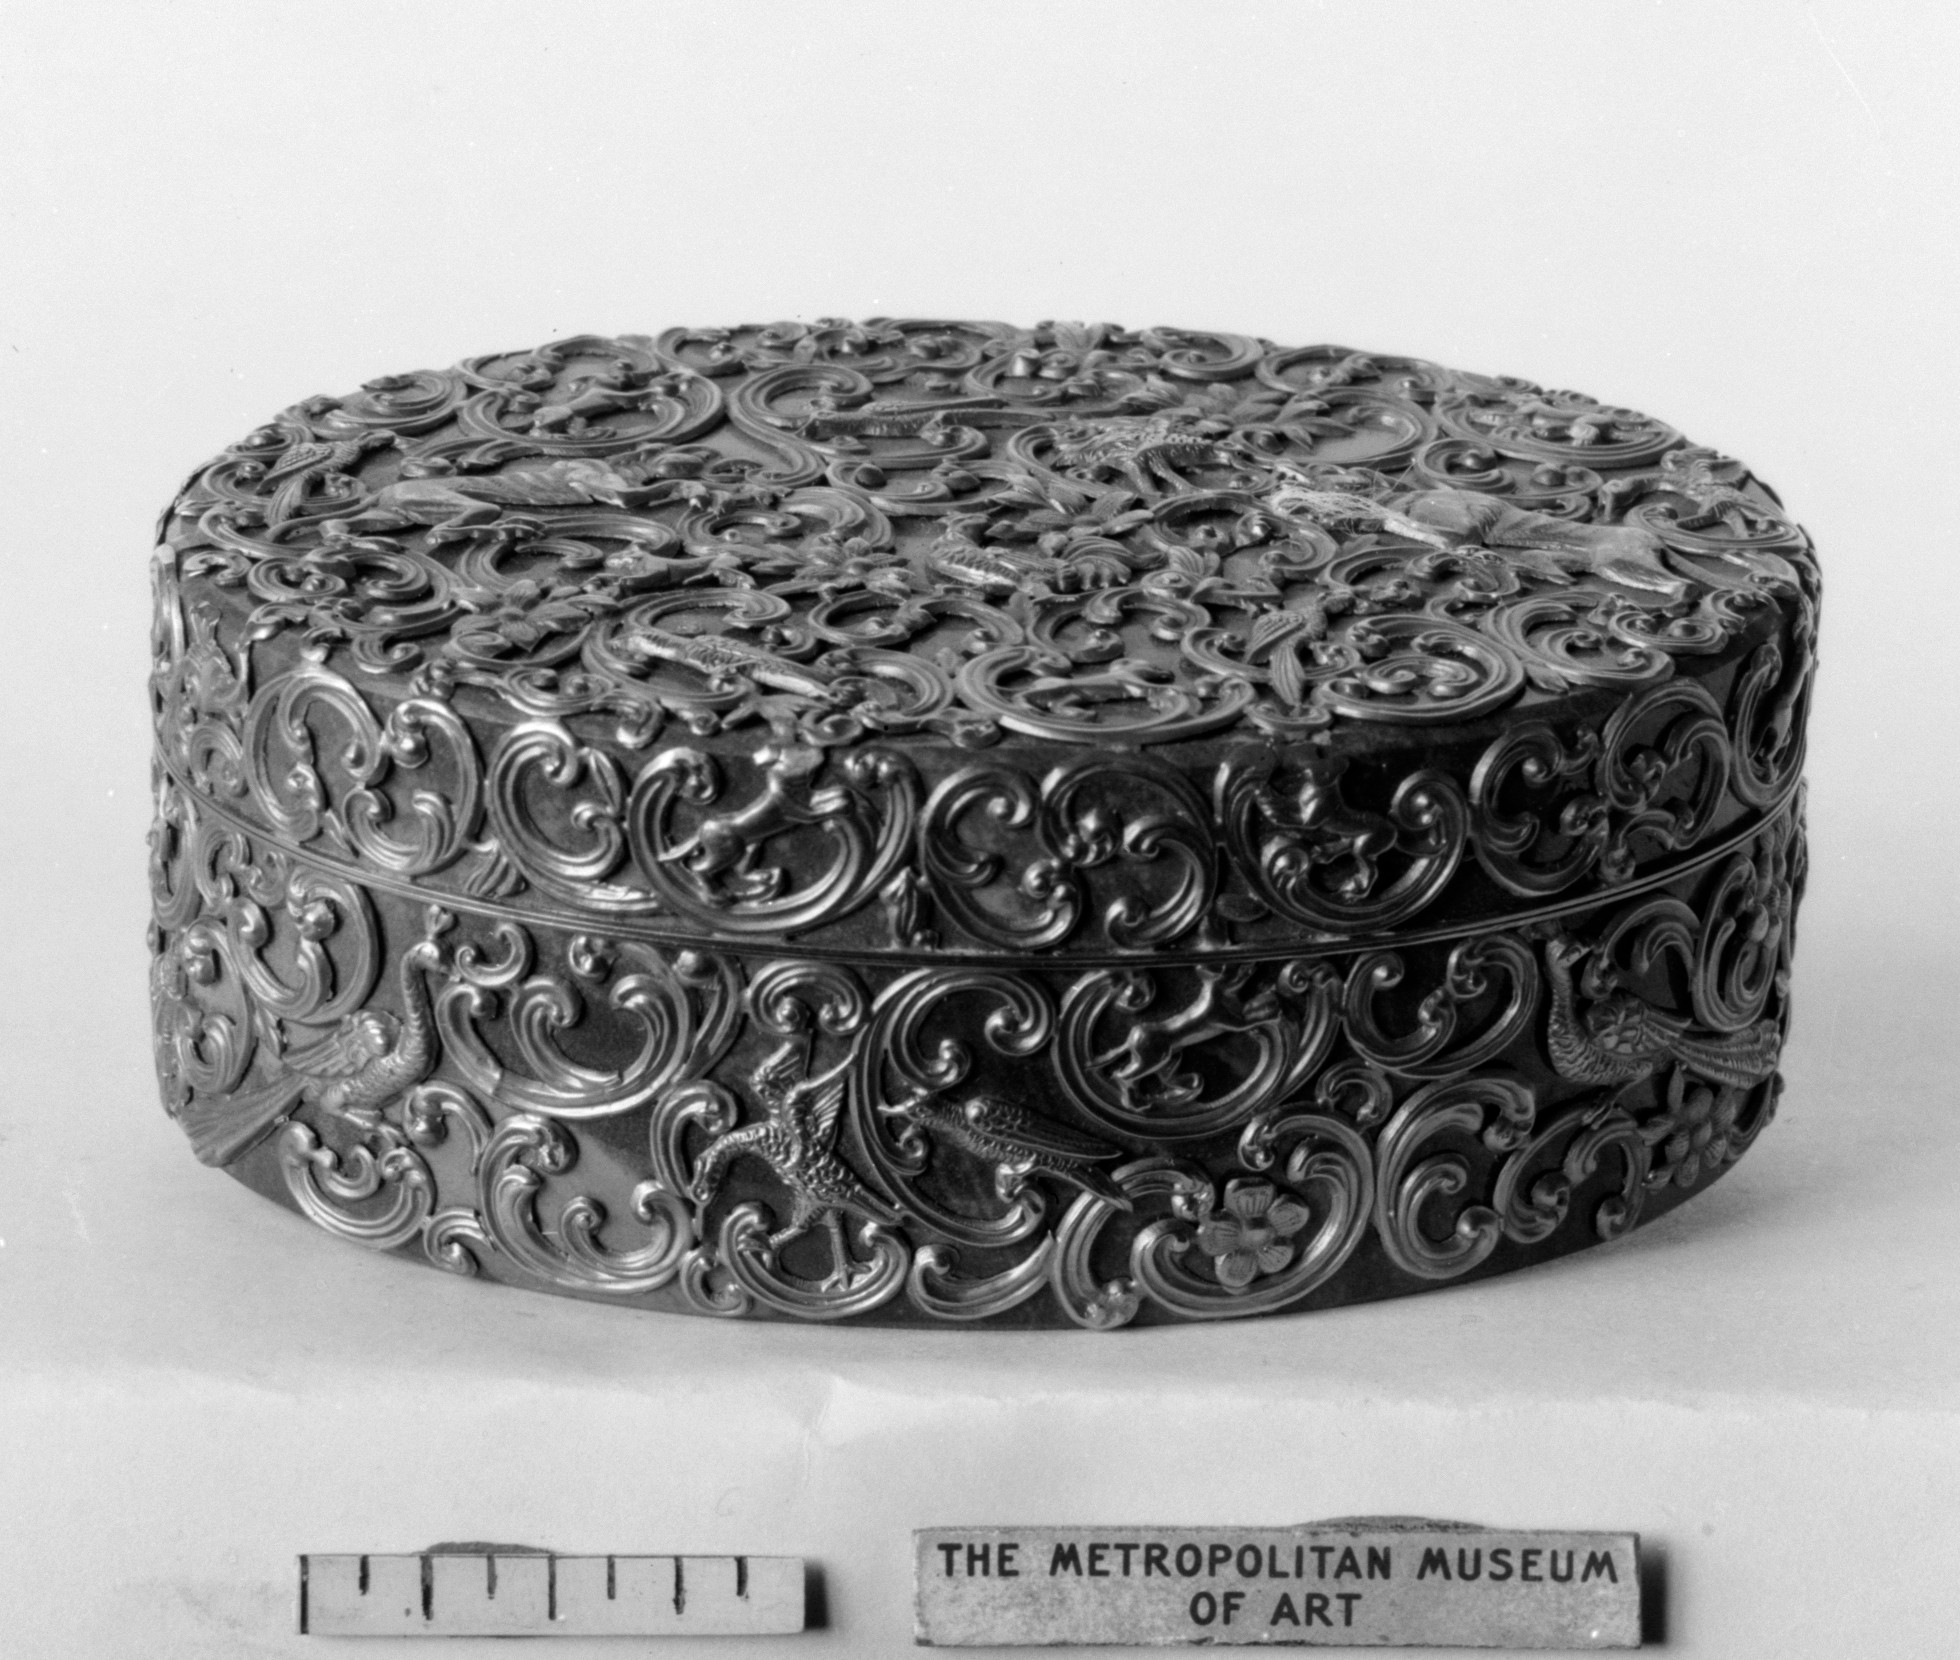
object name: snuffbox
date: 1701-1800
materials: gold, onyx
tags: eagles,peacocks